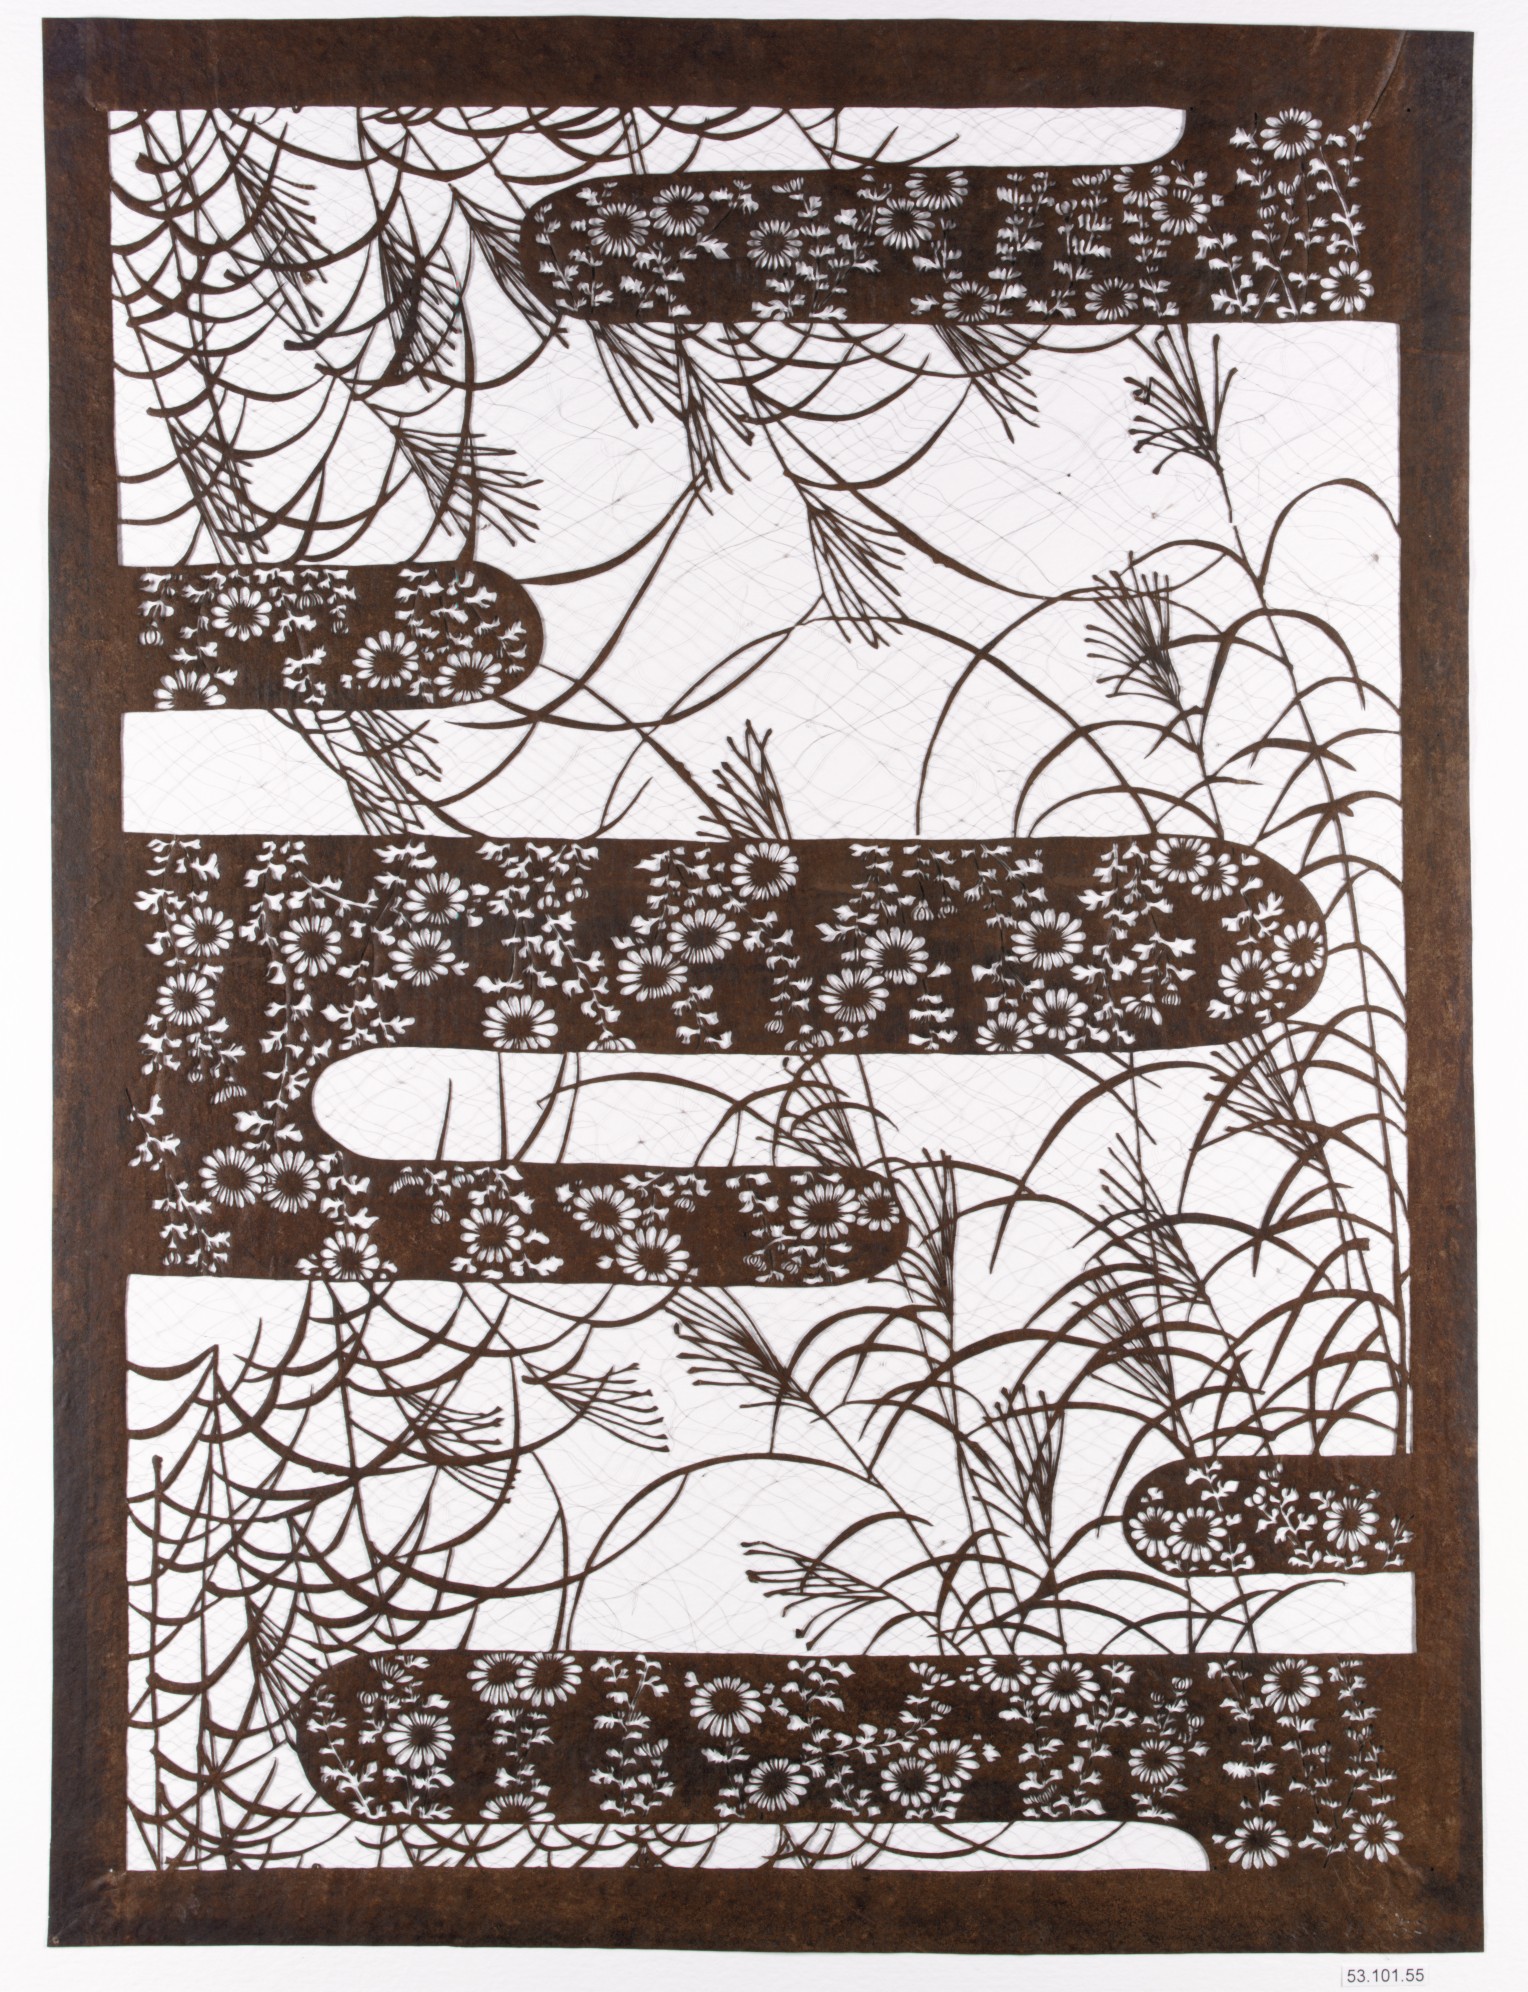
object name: stencil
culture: japanese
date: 1615-1868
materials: paper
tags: flowers